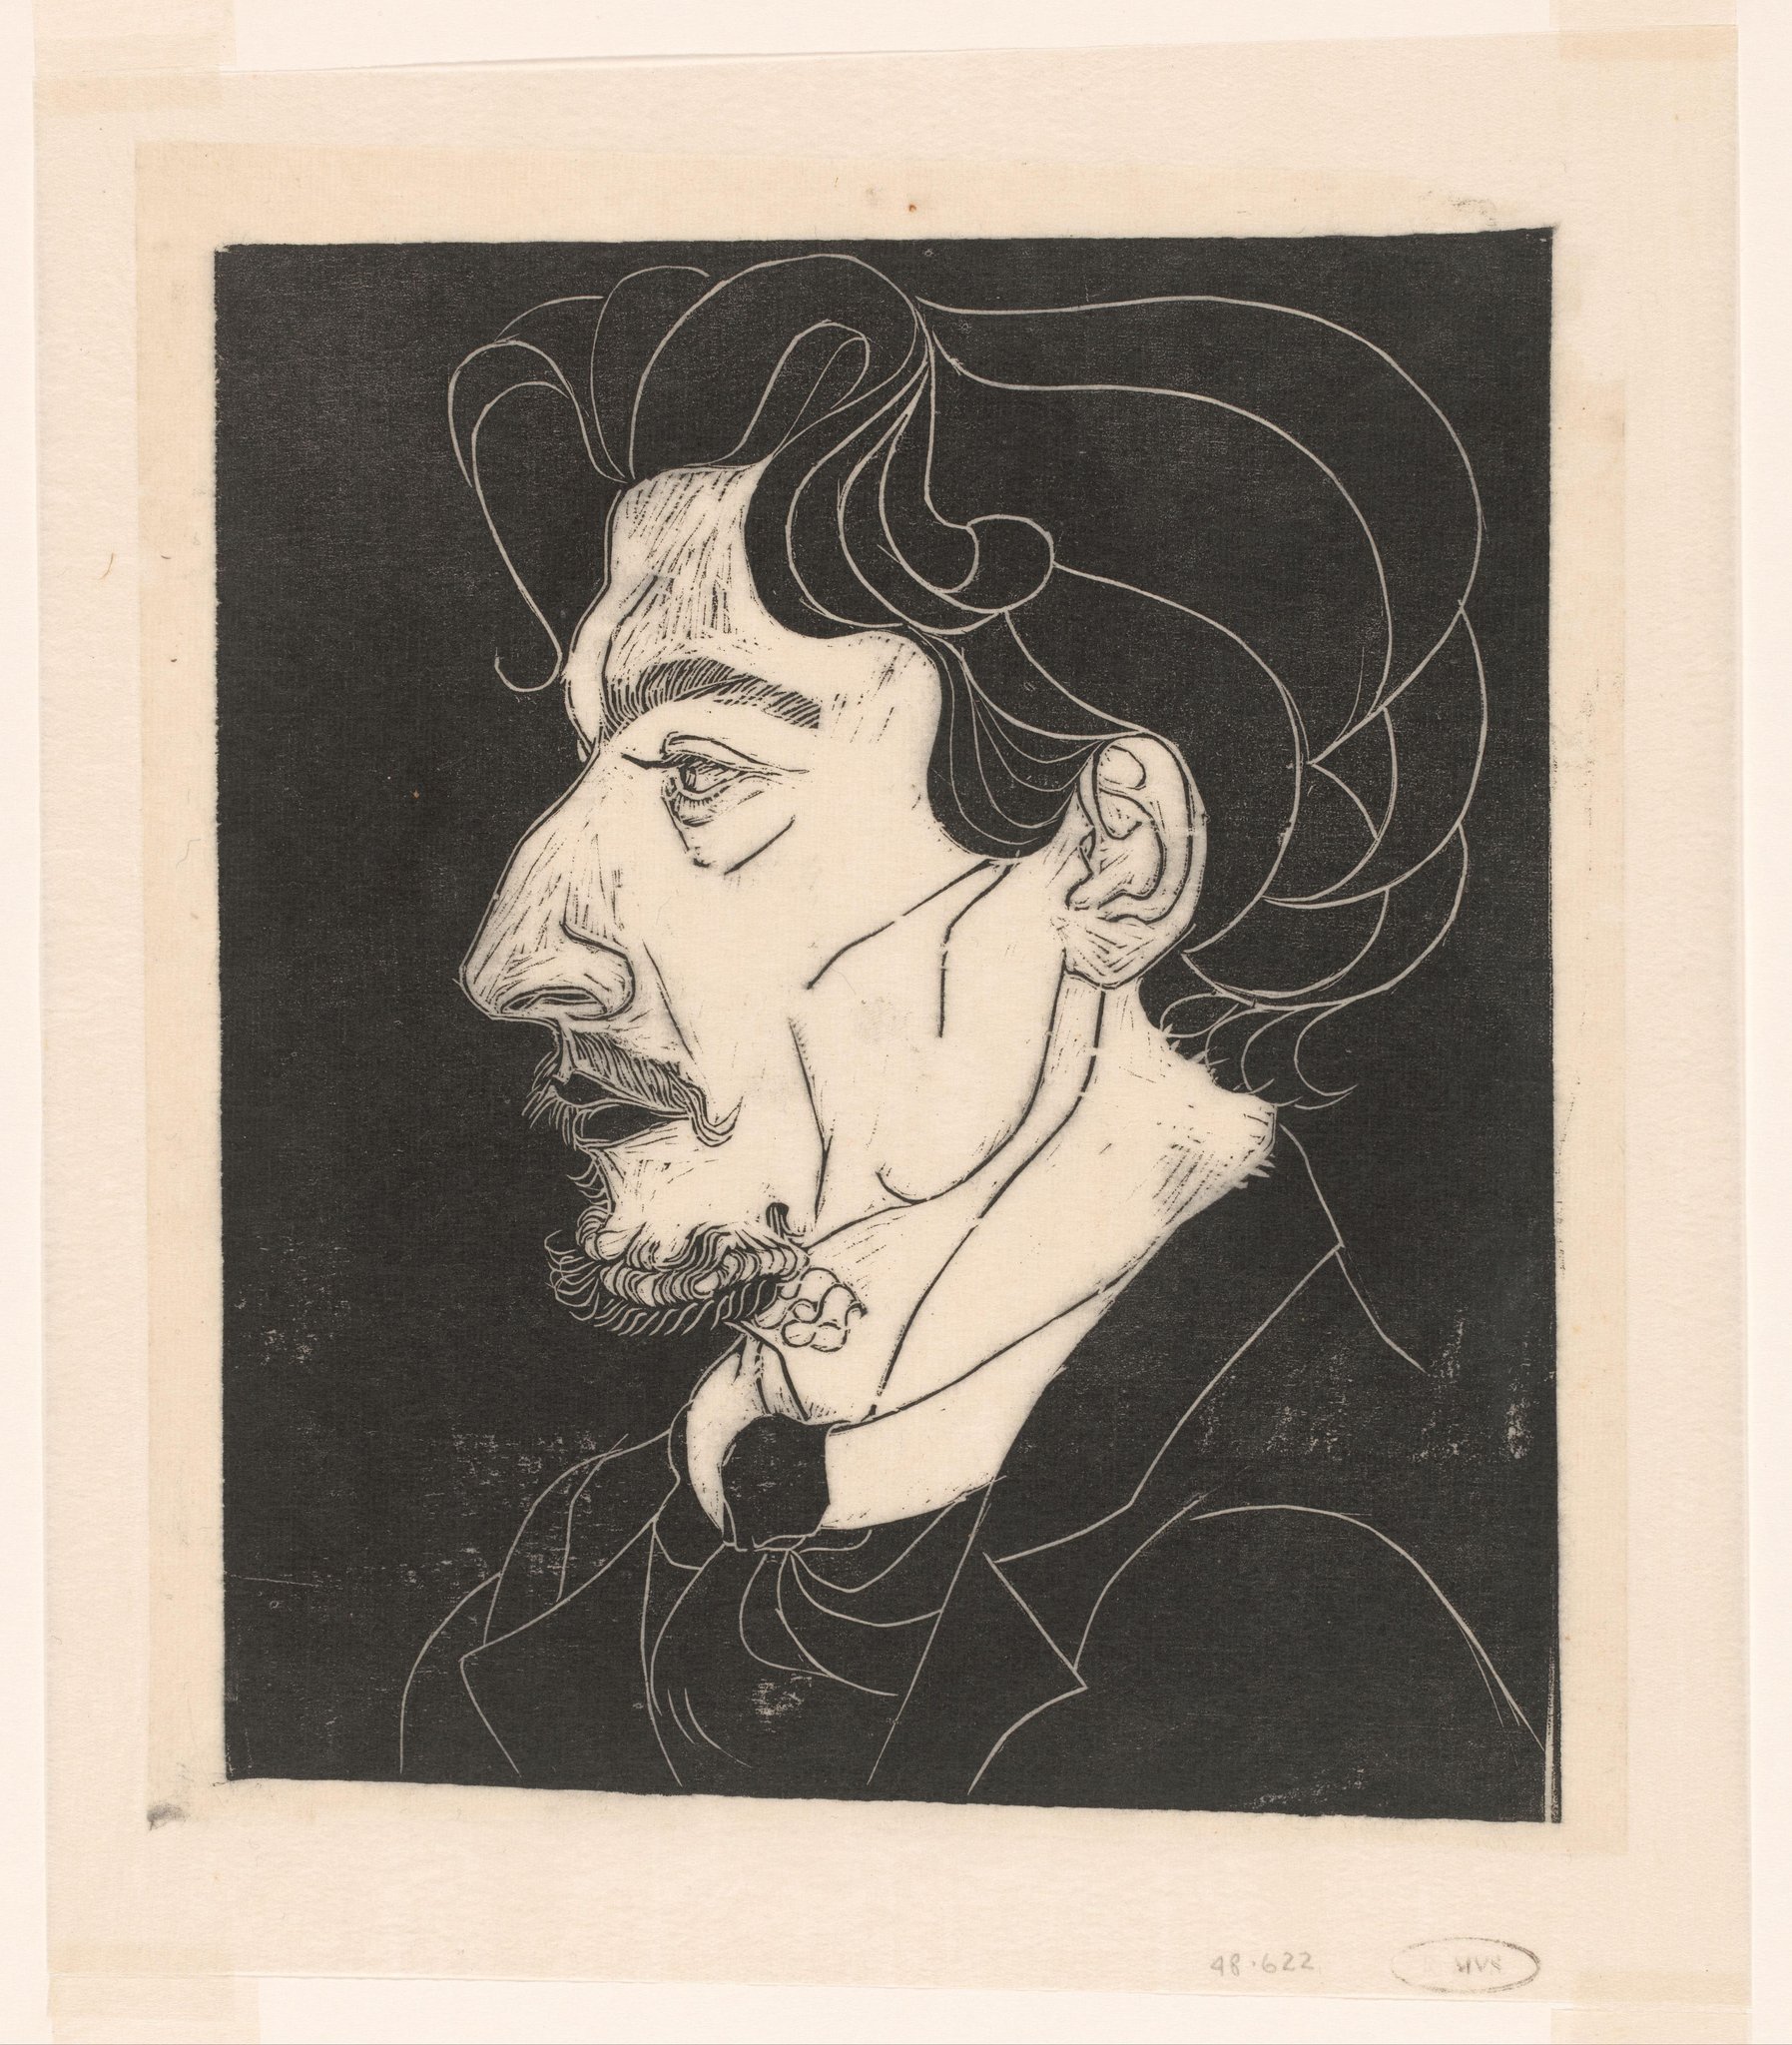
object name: print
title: Portret van Johan Briedé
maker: reijer stolk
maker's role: draughtsman, print maker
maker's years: 1896-1945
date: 1906-1945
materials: paper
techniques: woodcut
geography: netherlands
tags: rotterdam, amsterdam, print maker, draughtsman, johan briedé, portrait, self-portrait of artist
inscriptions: collector's mark: Lugt 2228